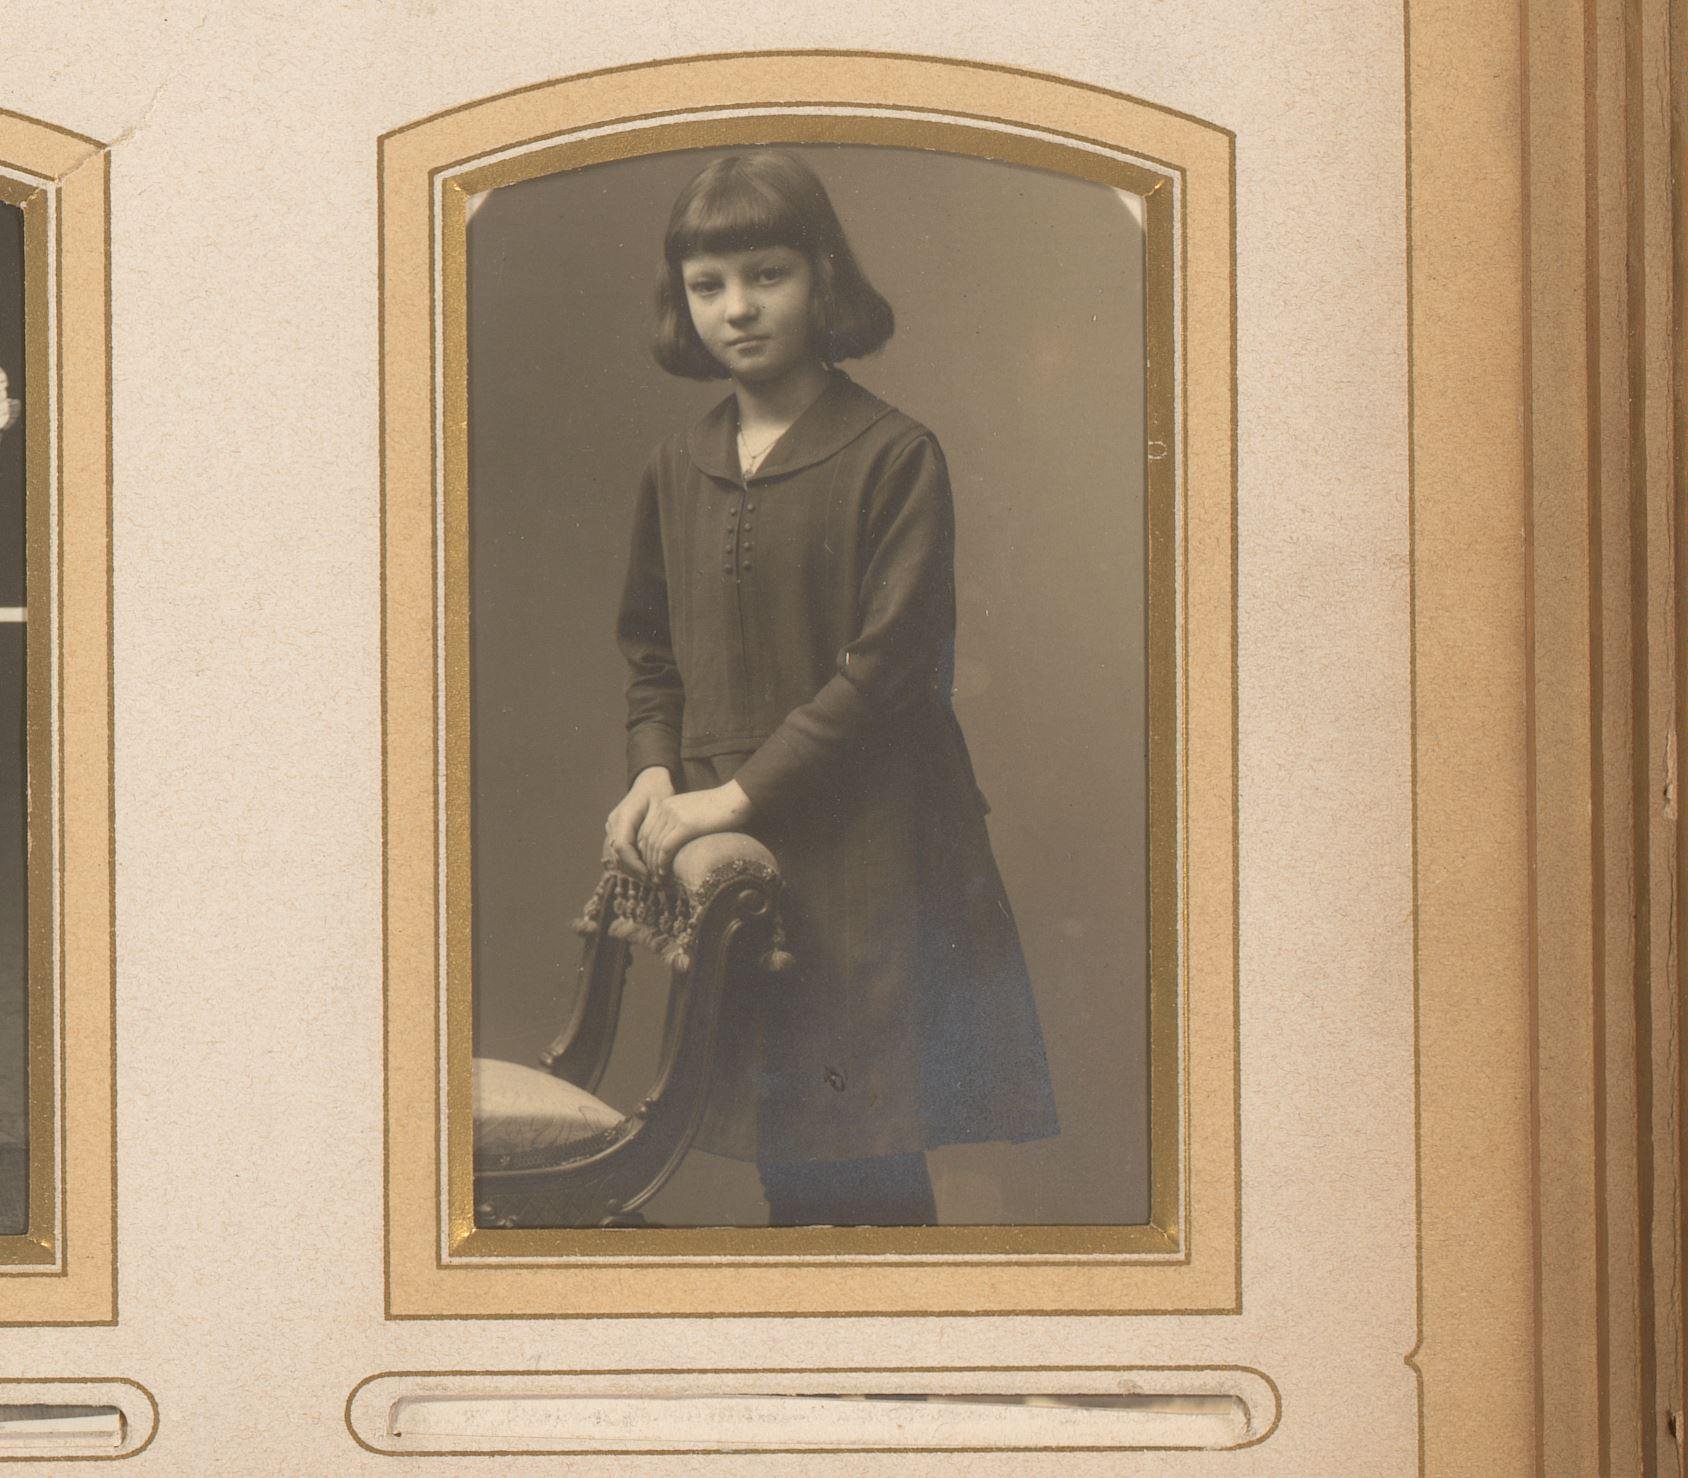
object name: photograph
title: Portret van een meisje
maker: Anonymous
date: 1890-1920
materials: cardboard, photographic support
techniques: gelatin silver print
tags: historical persons, girl (child between toddler and youth)